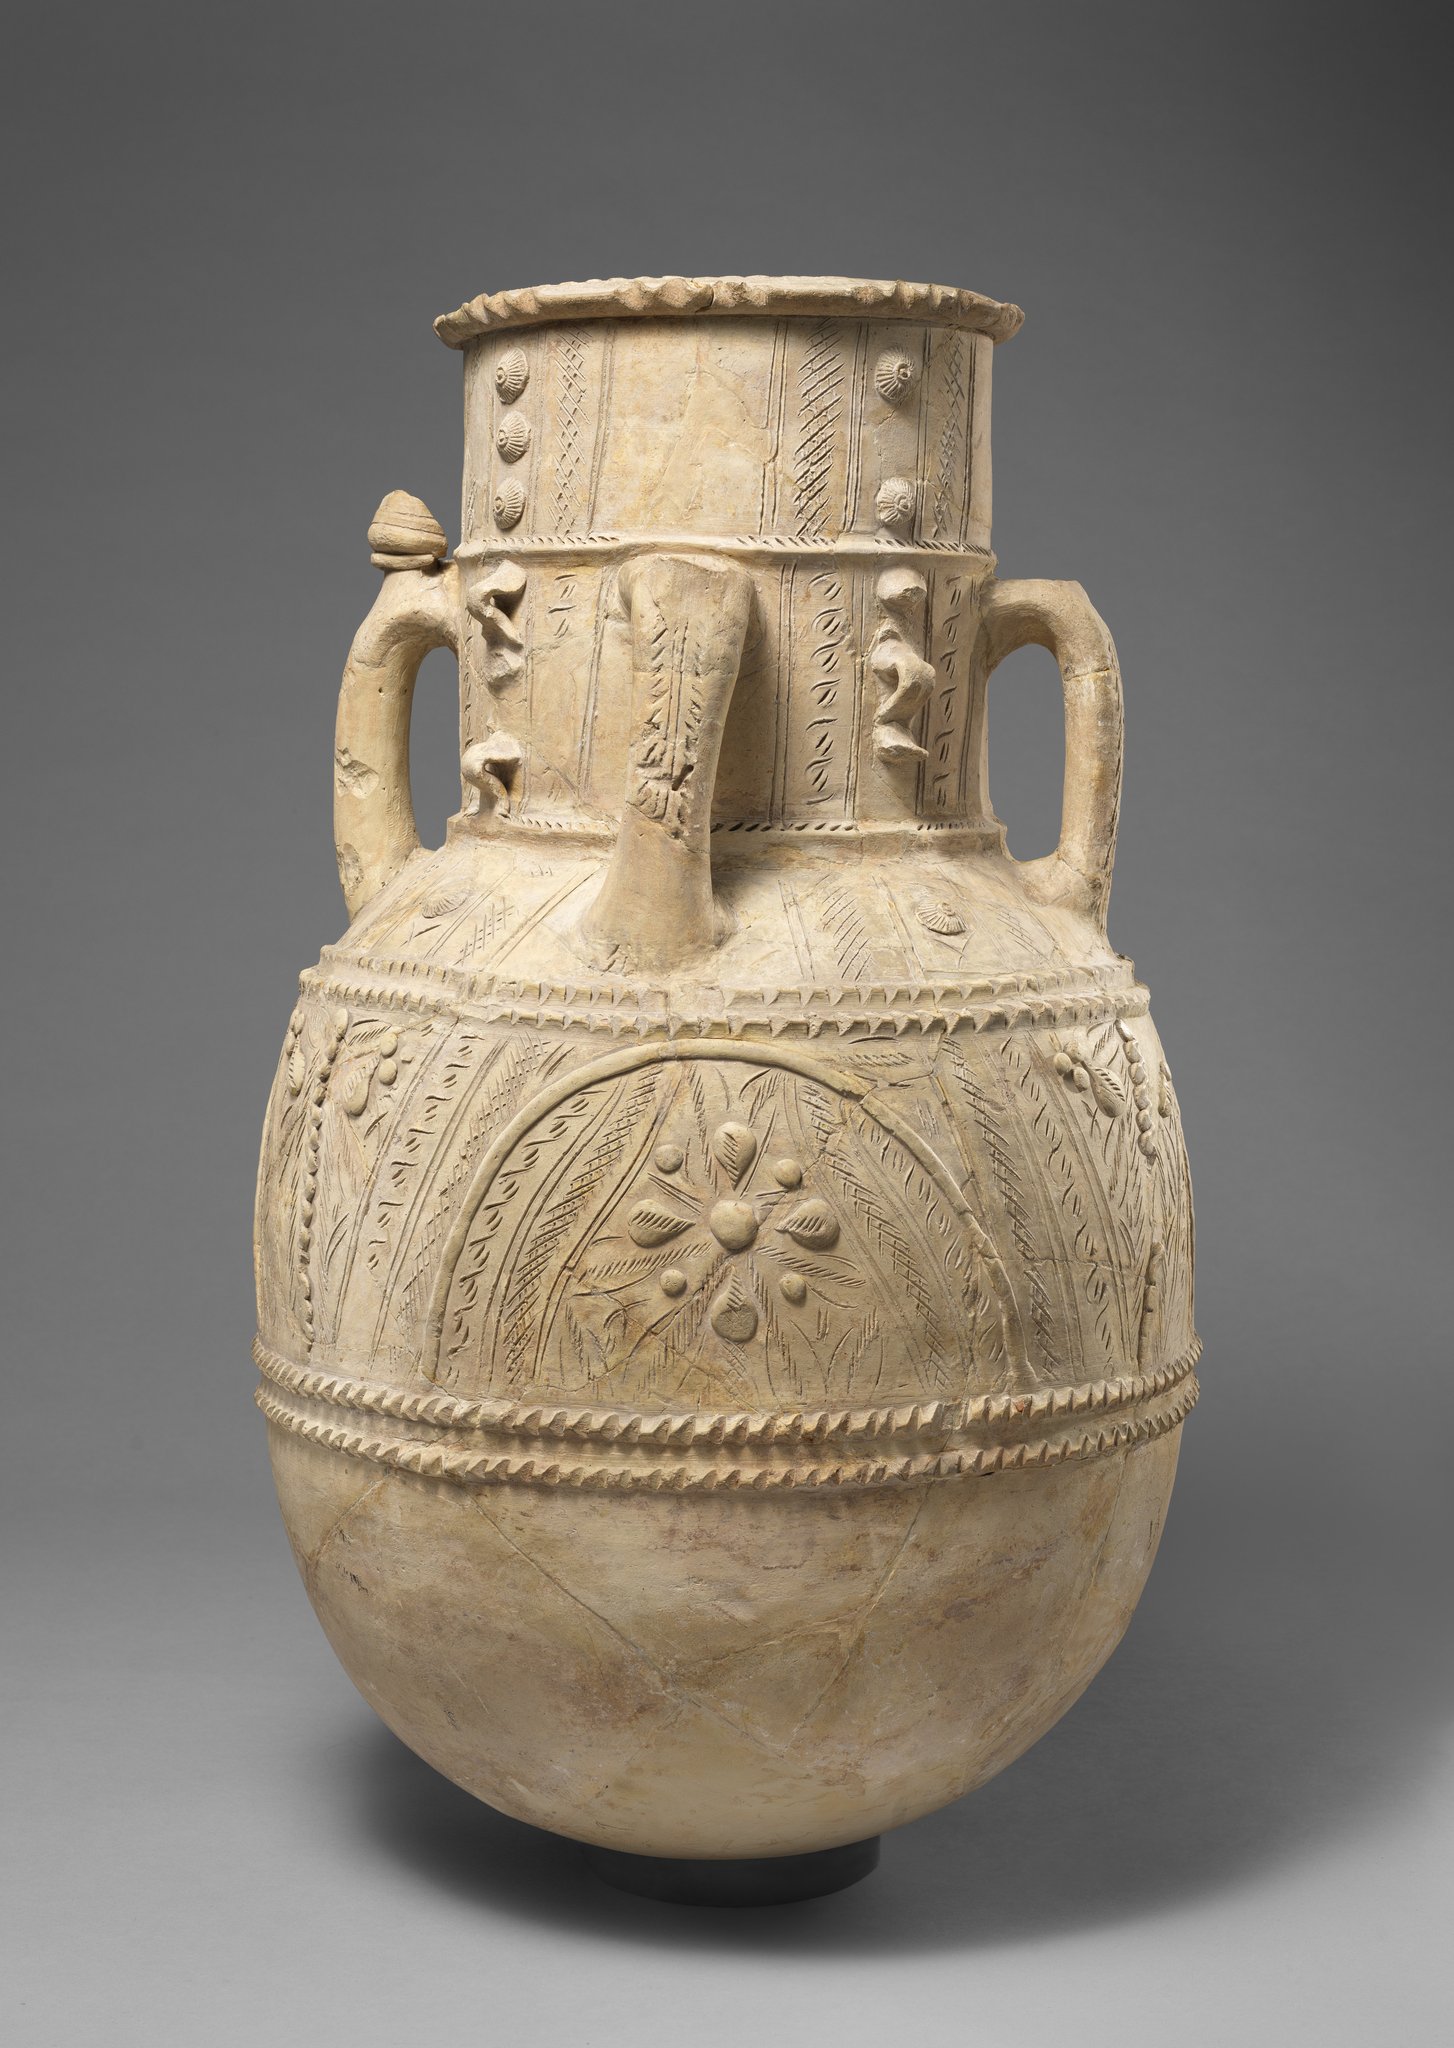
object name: jar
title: Large Storage Jar for Cool Water With Flower Motifs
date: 701-1000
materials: earthenware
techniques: incising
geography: iraq